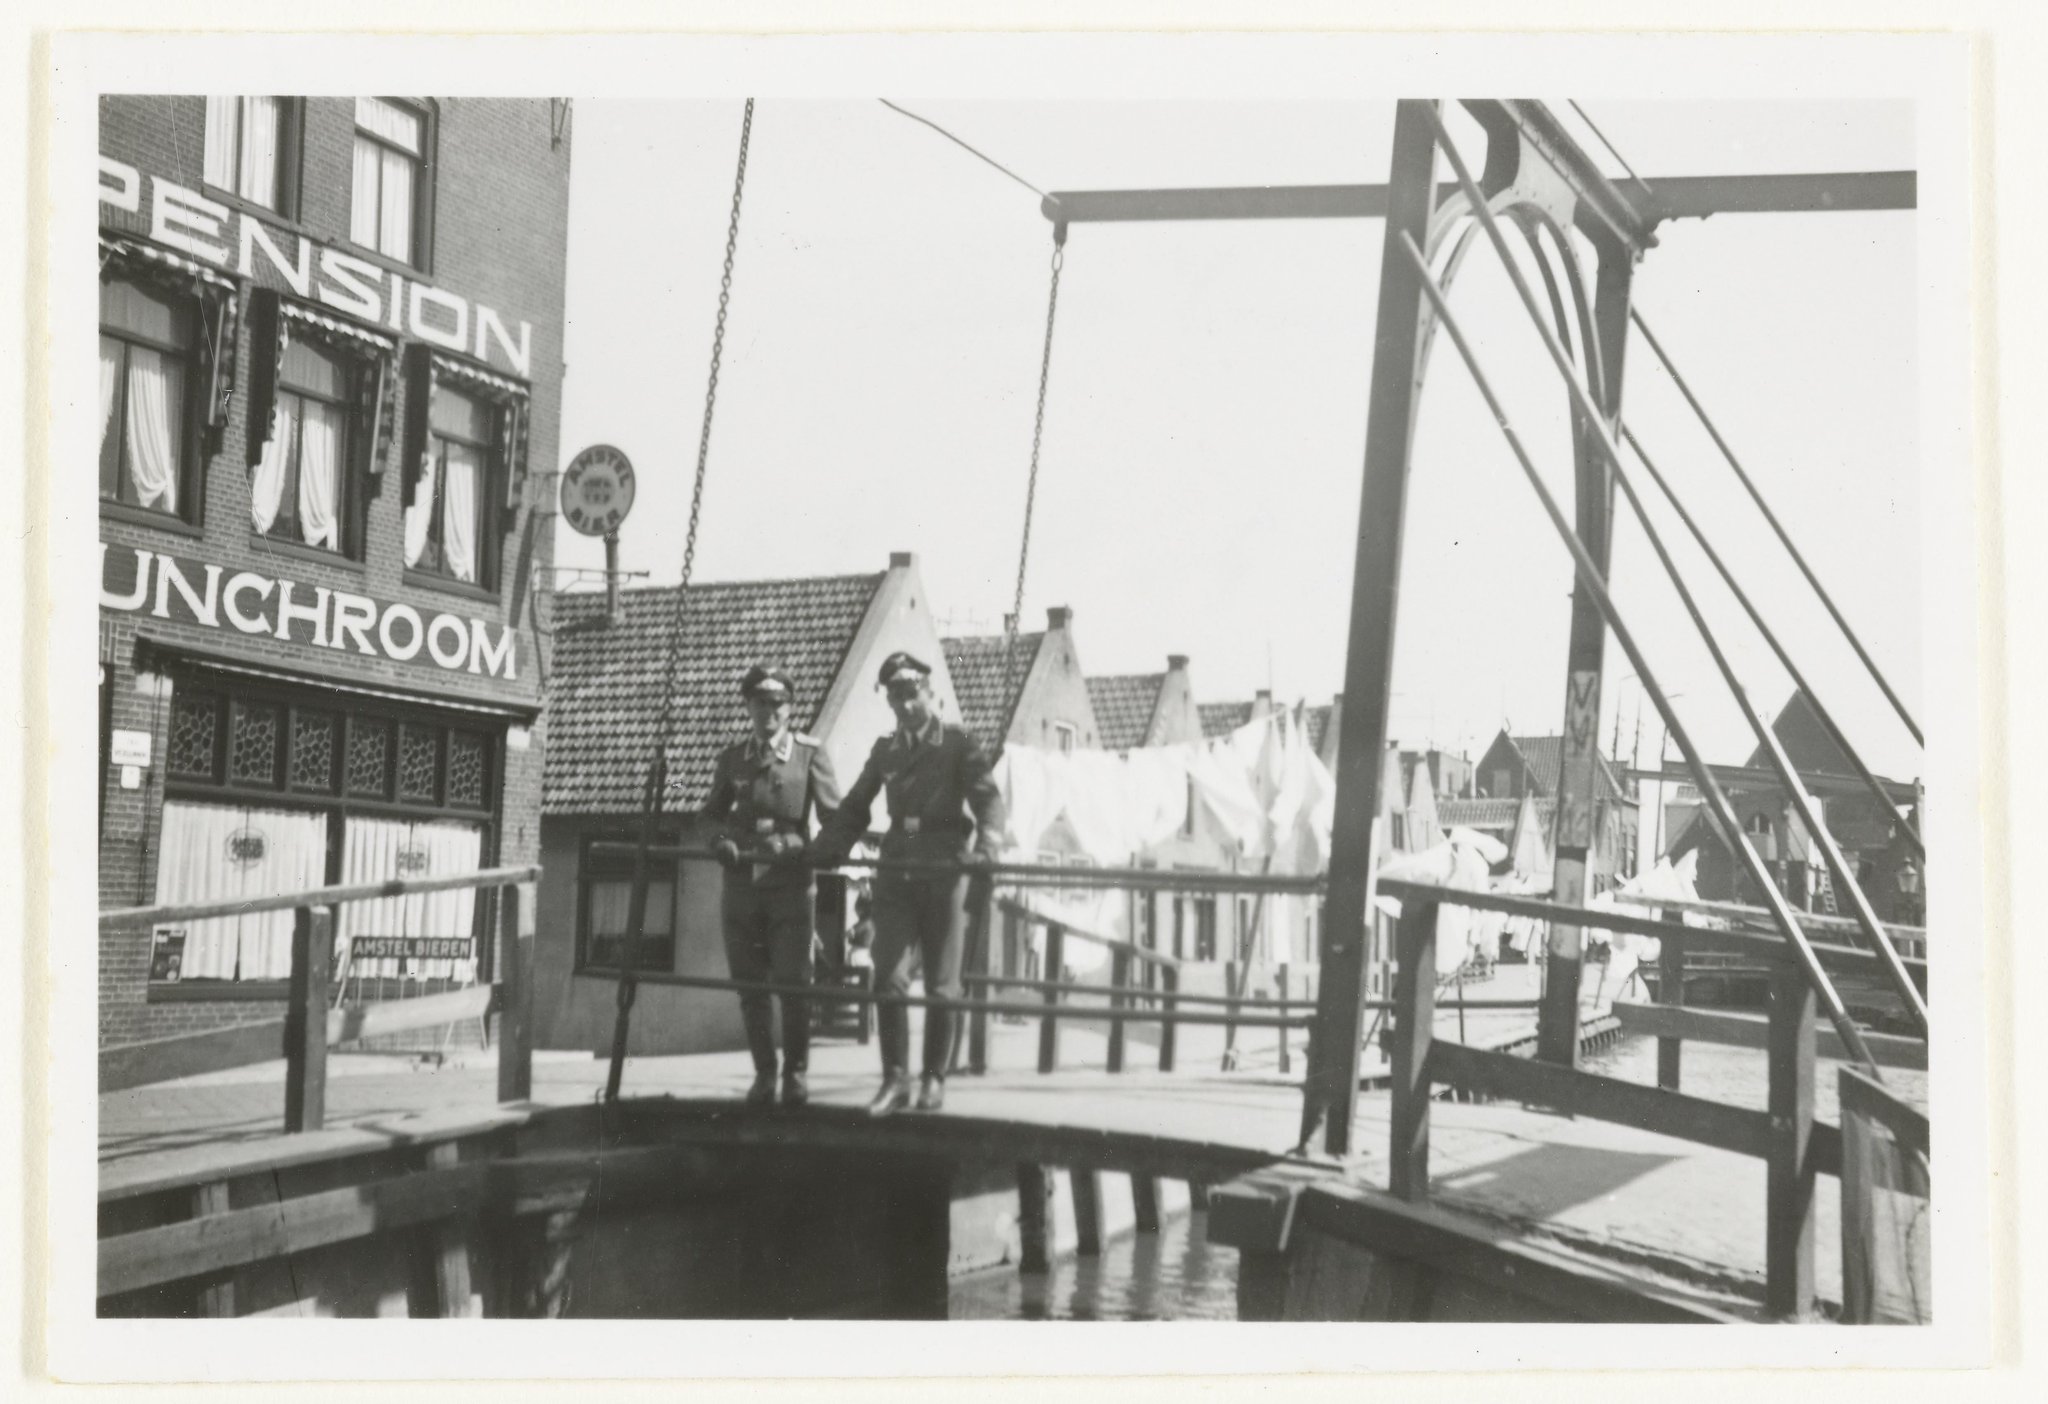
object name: photograph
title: Militairen van de Wehrmacht in Volendam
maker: Anonymous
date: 1942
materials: photographic support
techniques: gelatin silver print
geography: volendam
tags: recreation ~ the soldier off duty, occupation ~ war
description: Twee Duitse militairen brengen een bezoek aan Volendam. Zij staan op een ophaalbruggetje, achter hen hangt de witte was te drogen. Links een Pension/ Lunchroom.